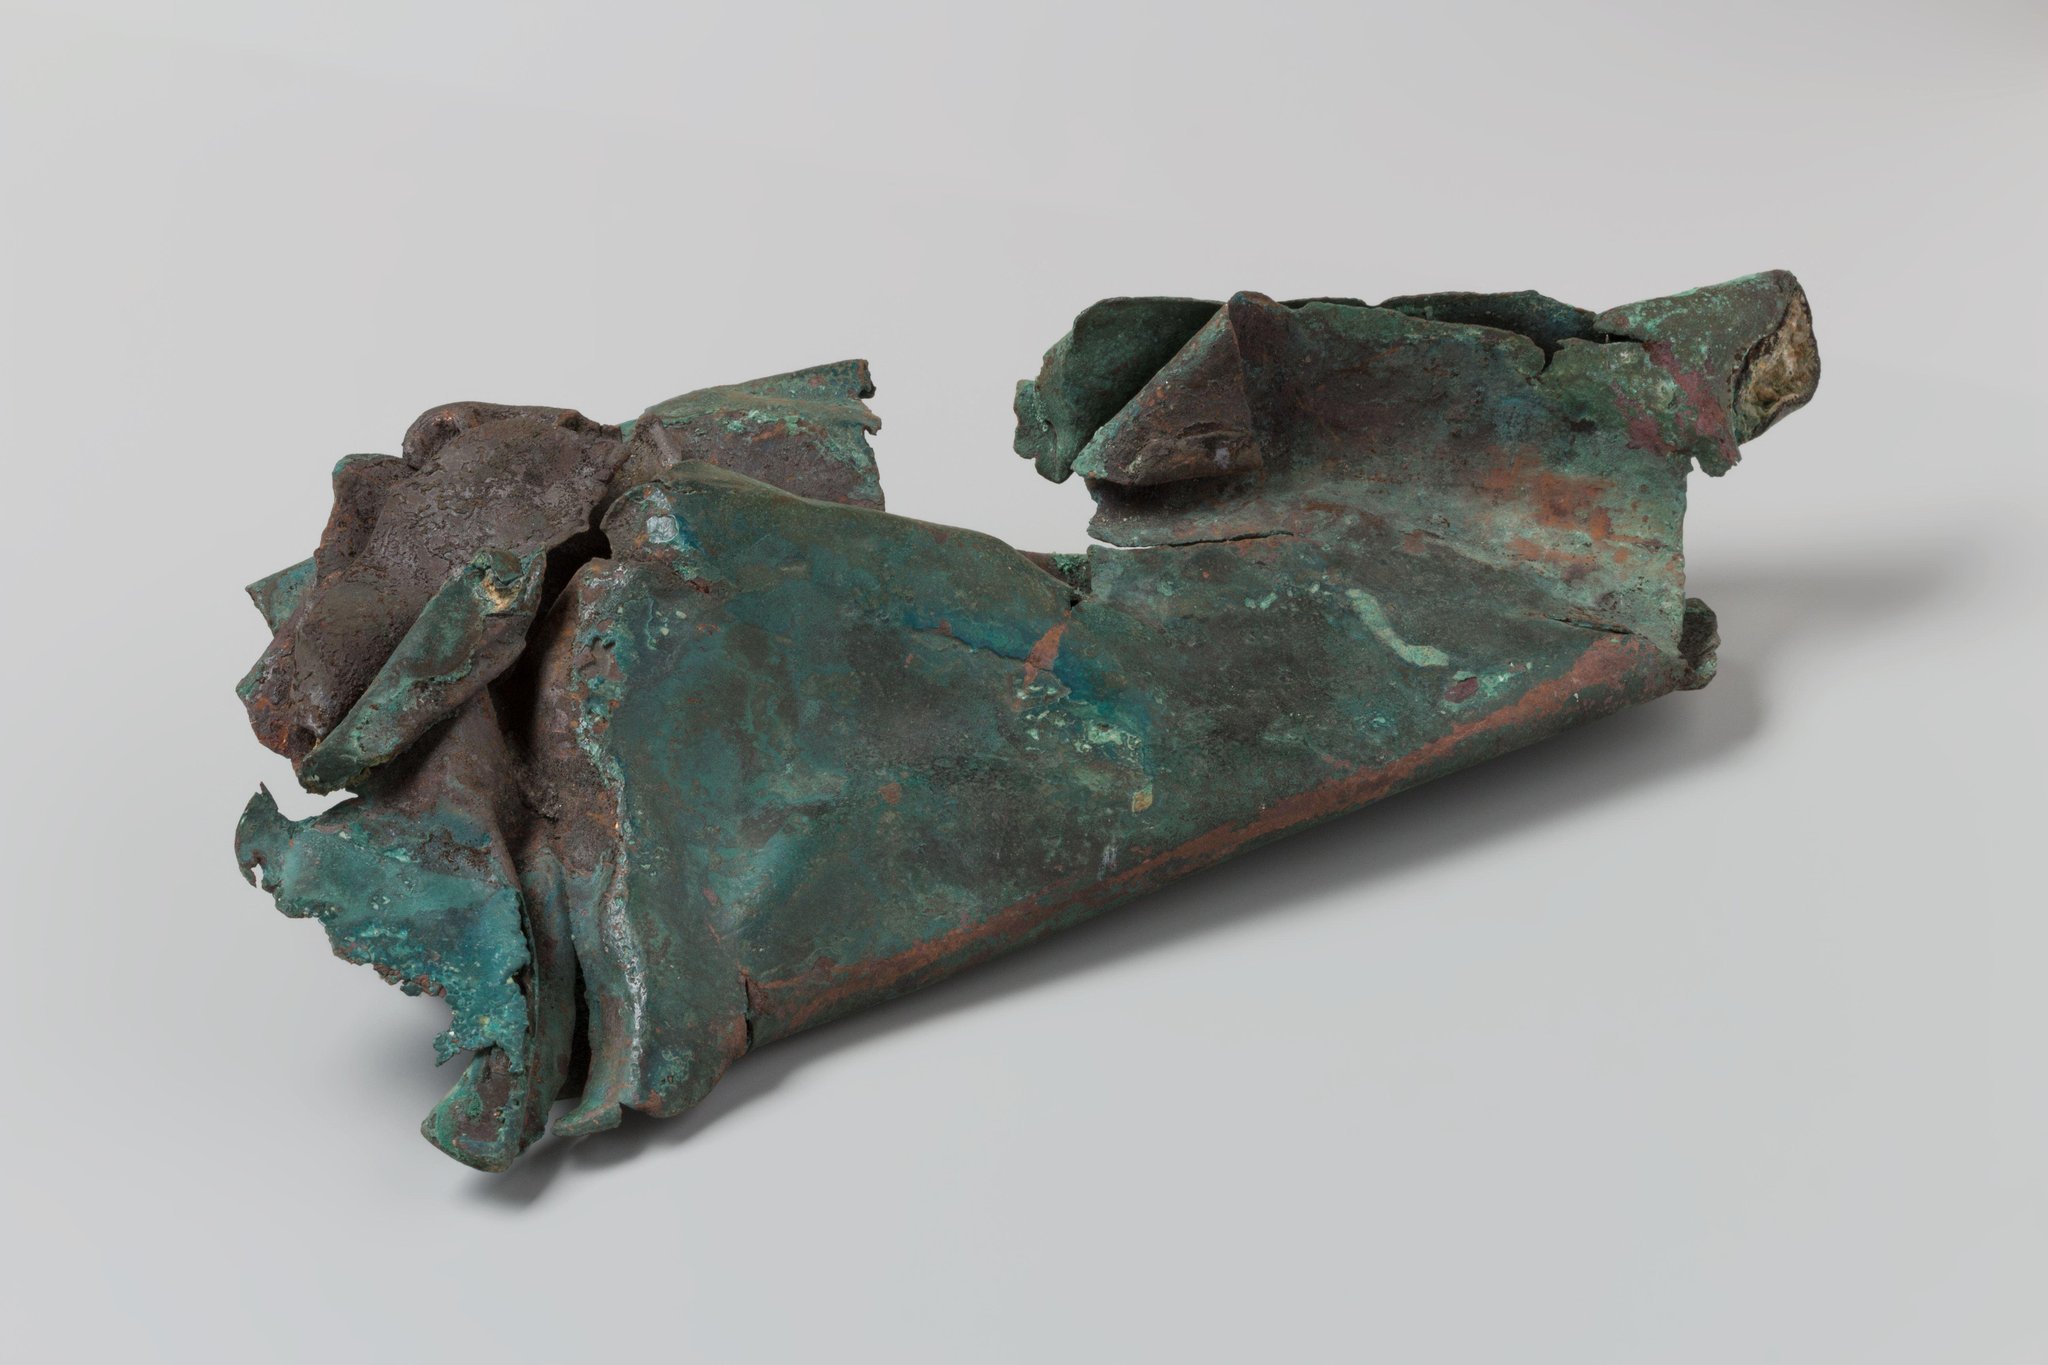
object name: scheepswrakvondst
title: Fragment dubbelgevouwen plaatwerk uit het wrak van de Oost-Indiëvaarder Hollandia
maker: Anonymous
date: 1700-1743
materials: copper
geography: netherlands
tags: verenigde oostindische compagnie, hollandia (schip), annet